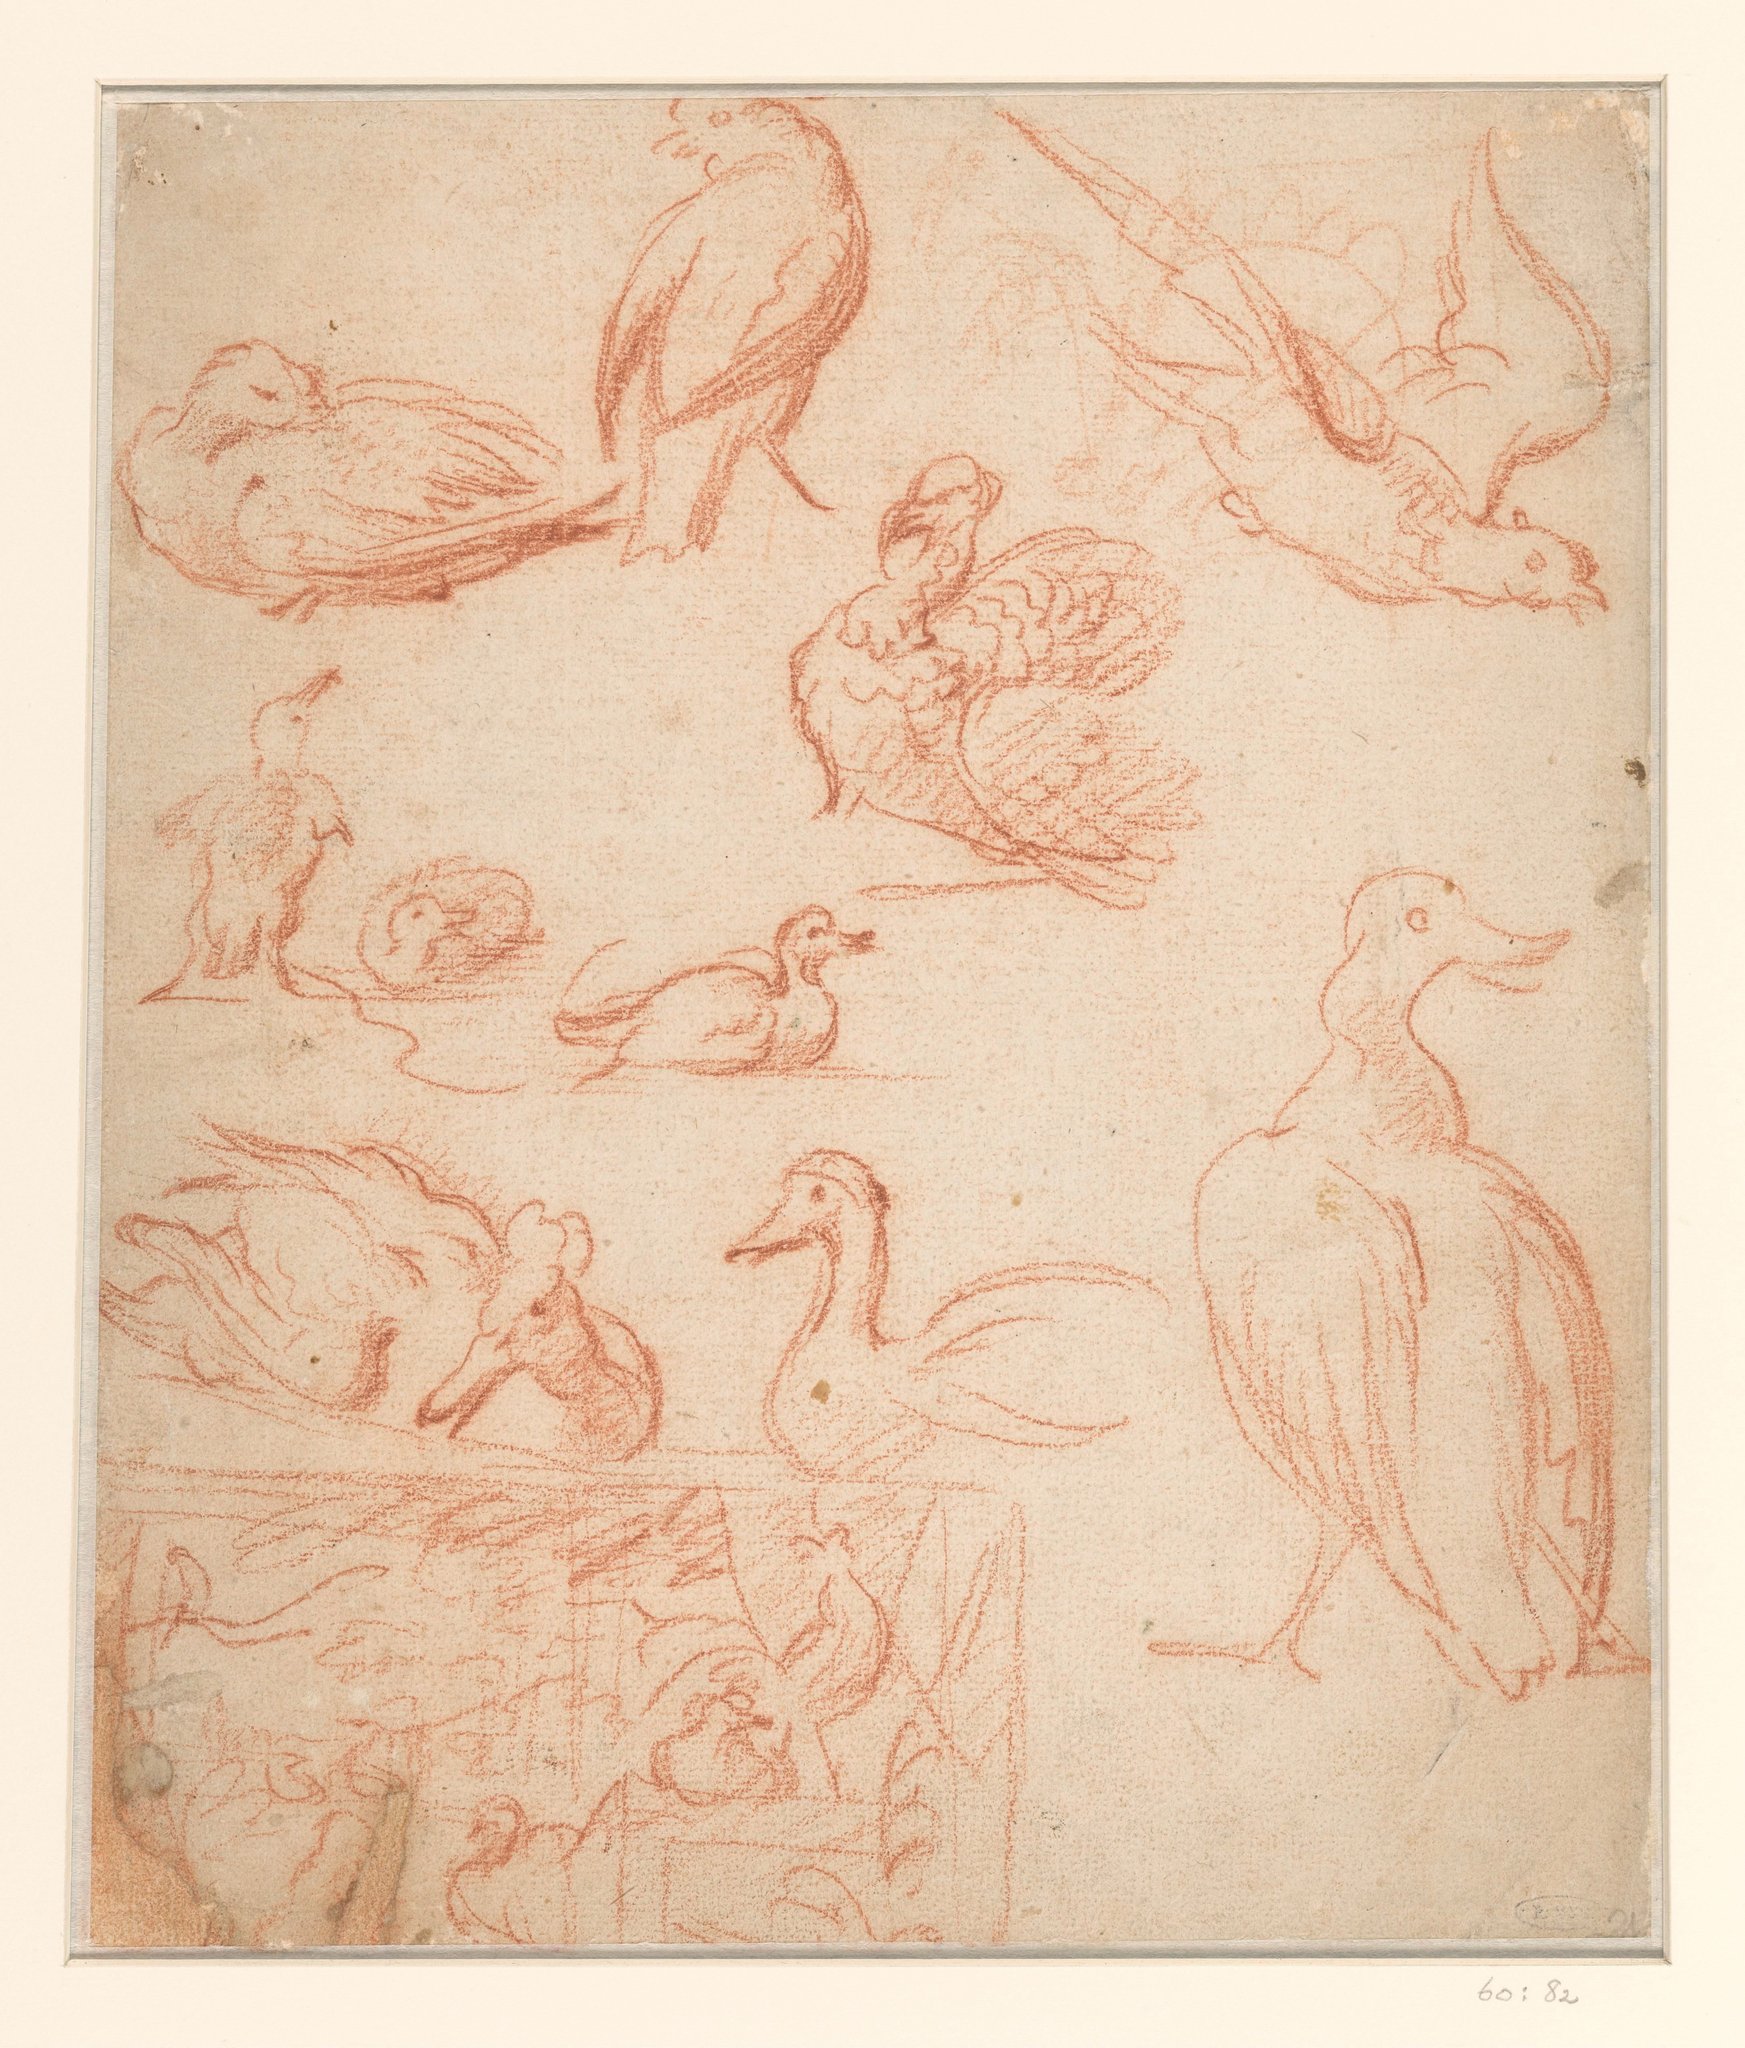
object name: drawing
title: Schetsen van een compositie en verschillende vogels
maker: melchior d hondecoeter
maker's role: draughtsman, painter, print maker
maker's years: 1636-1695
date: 1646-1695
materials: chalk, paper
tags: ornamental birds: cockatoo, water-birds: duck, walker and runner birds: turkey, doves, pigeons